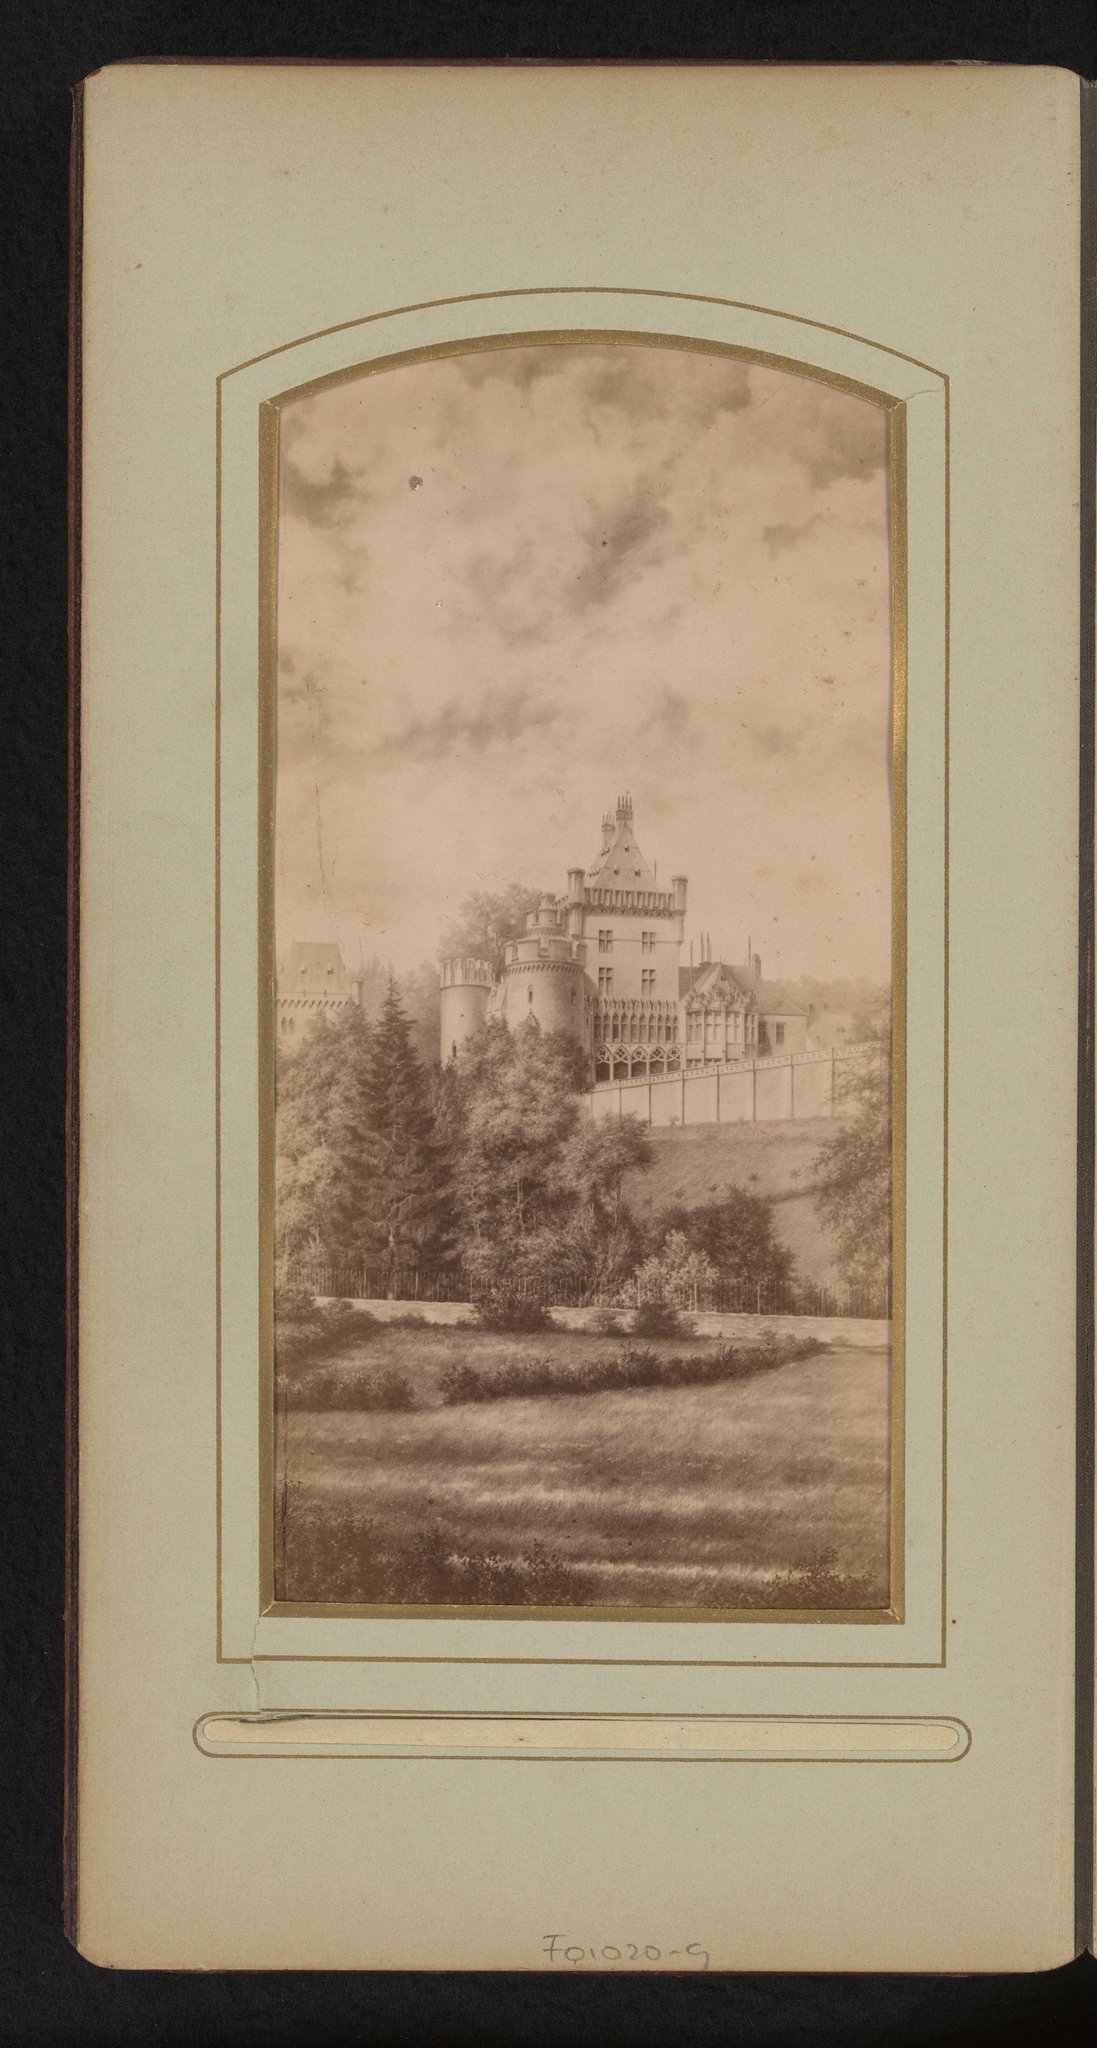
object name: photograph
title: Fotoreproductie van een prent van een kasteel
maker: nicolas maroldt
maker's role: fotograaf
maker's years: 1843-1906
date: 1860-1889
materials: photographic support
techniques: albumen print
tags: trees, castle, the graphic arts